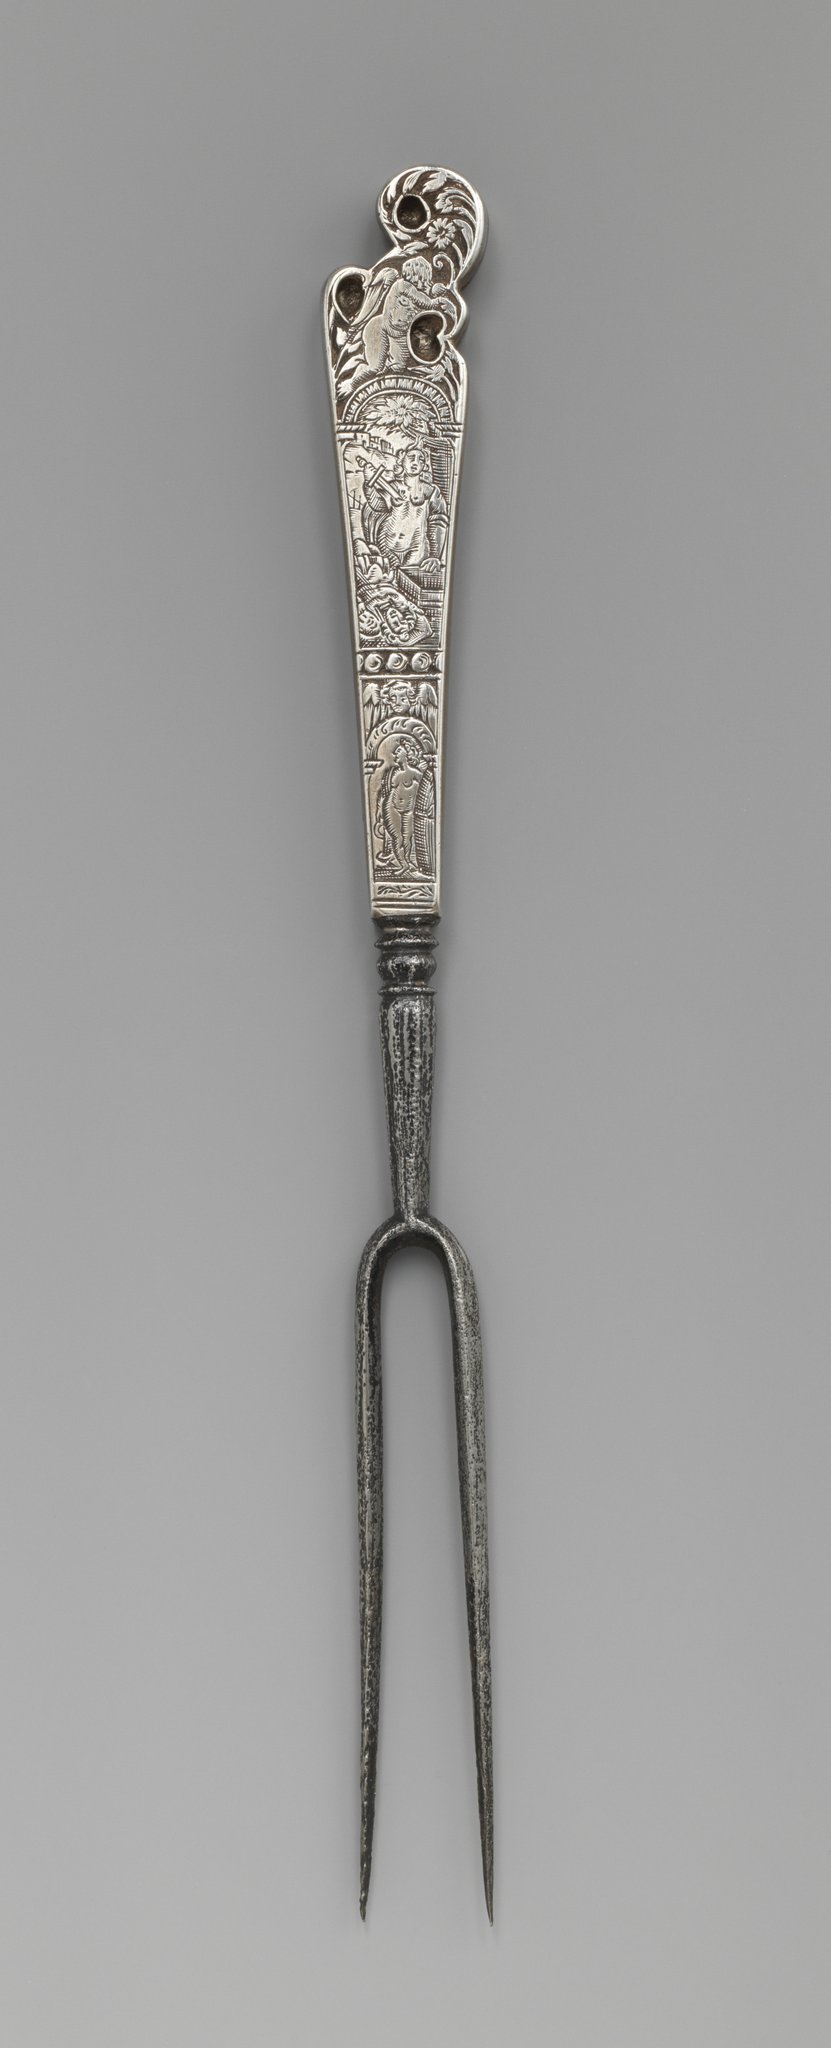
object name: fork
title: Fork with engraved mythological figures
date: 1601-1650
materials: silver, steel